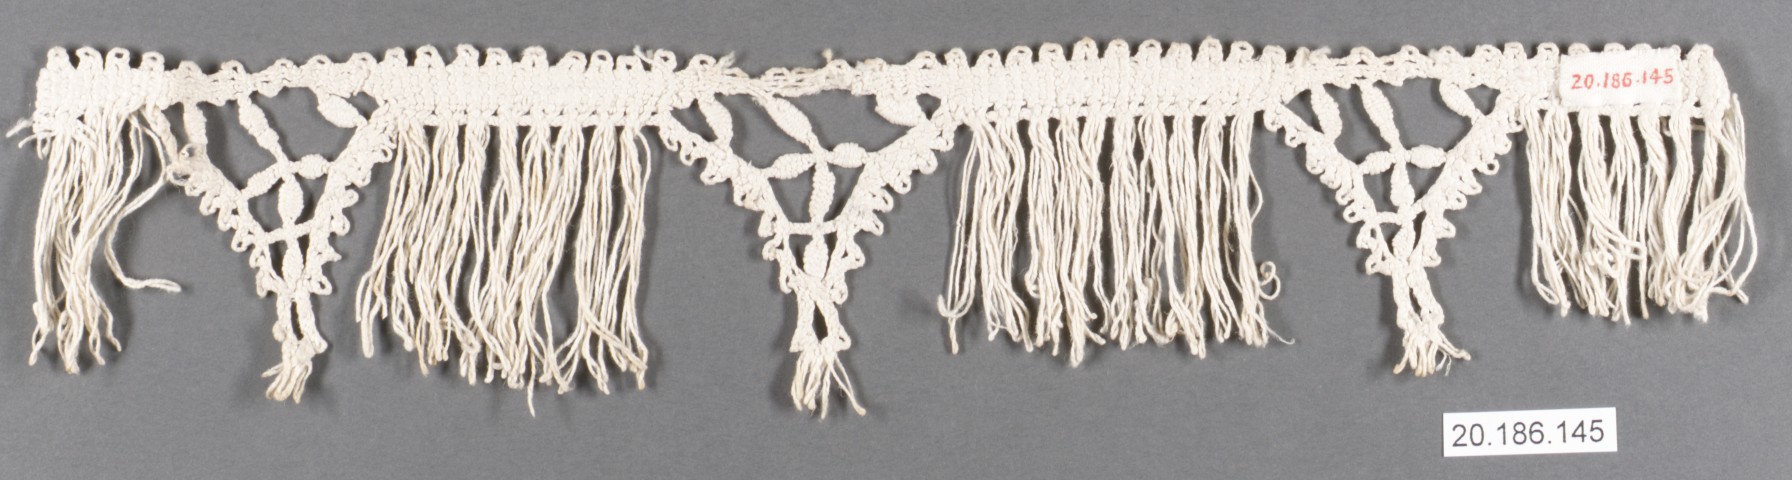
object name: edging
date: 1551-1600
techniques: lace